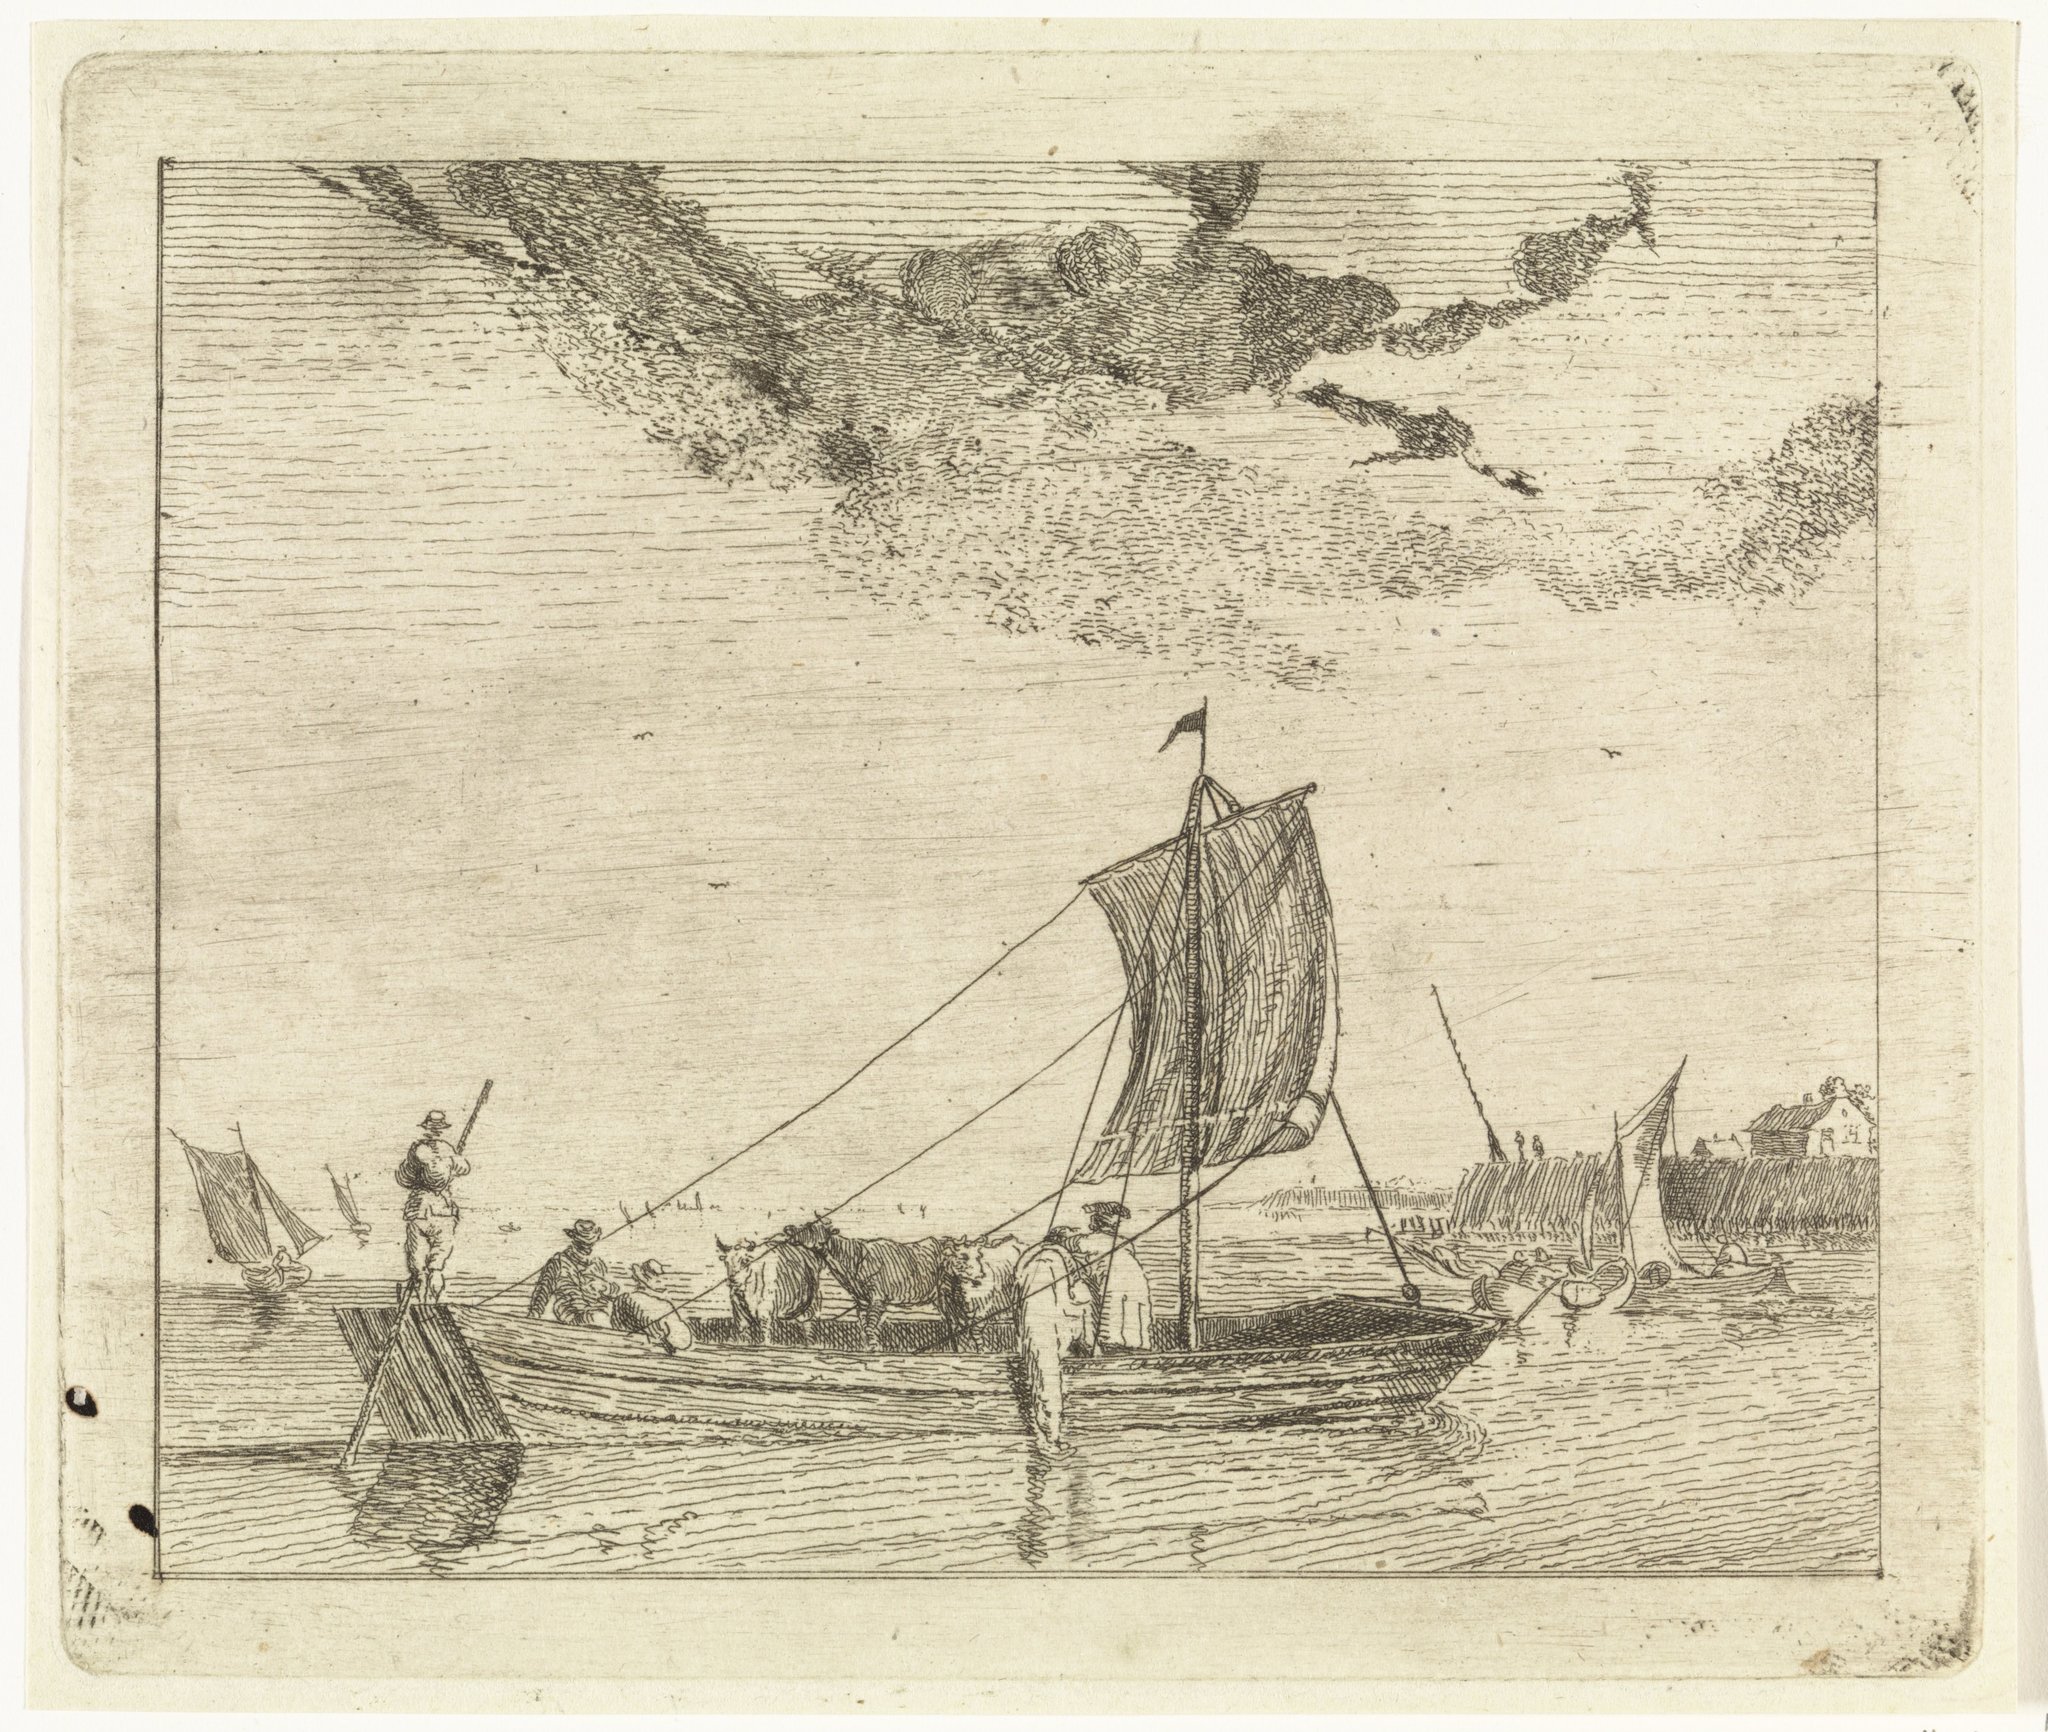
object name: print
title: Platte schuit met vee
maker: johannes huibert prins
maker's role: draughtsman, painter, print maker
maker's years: 1757-1806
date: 1776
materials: paper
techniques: etching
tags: cattle, ferry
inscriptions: collector's mark: Lugt 240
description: Op een platte schuit met gehesen zeil zitten twee mannen. De schipper staat met een duwboom achter op de boot. Op de schuit staan ook drie koeien en een ruiter met zijn paard, dat zich voorover buigt naar het water om te drinken.